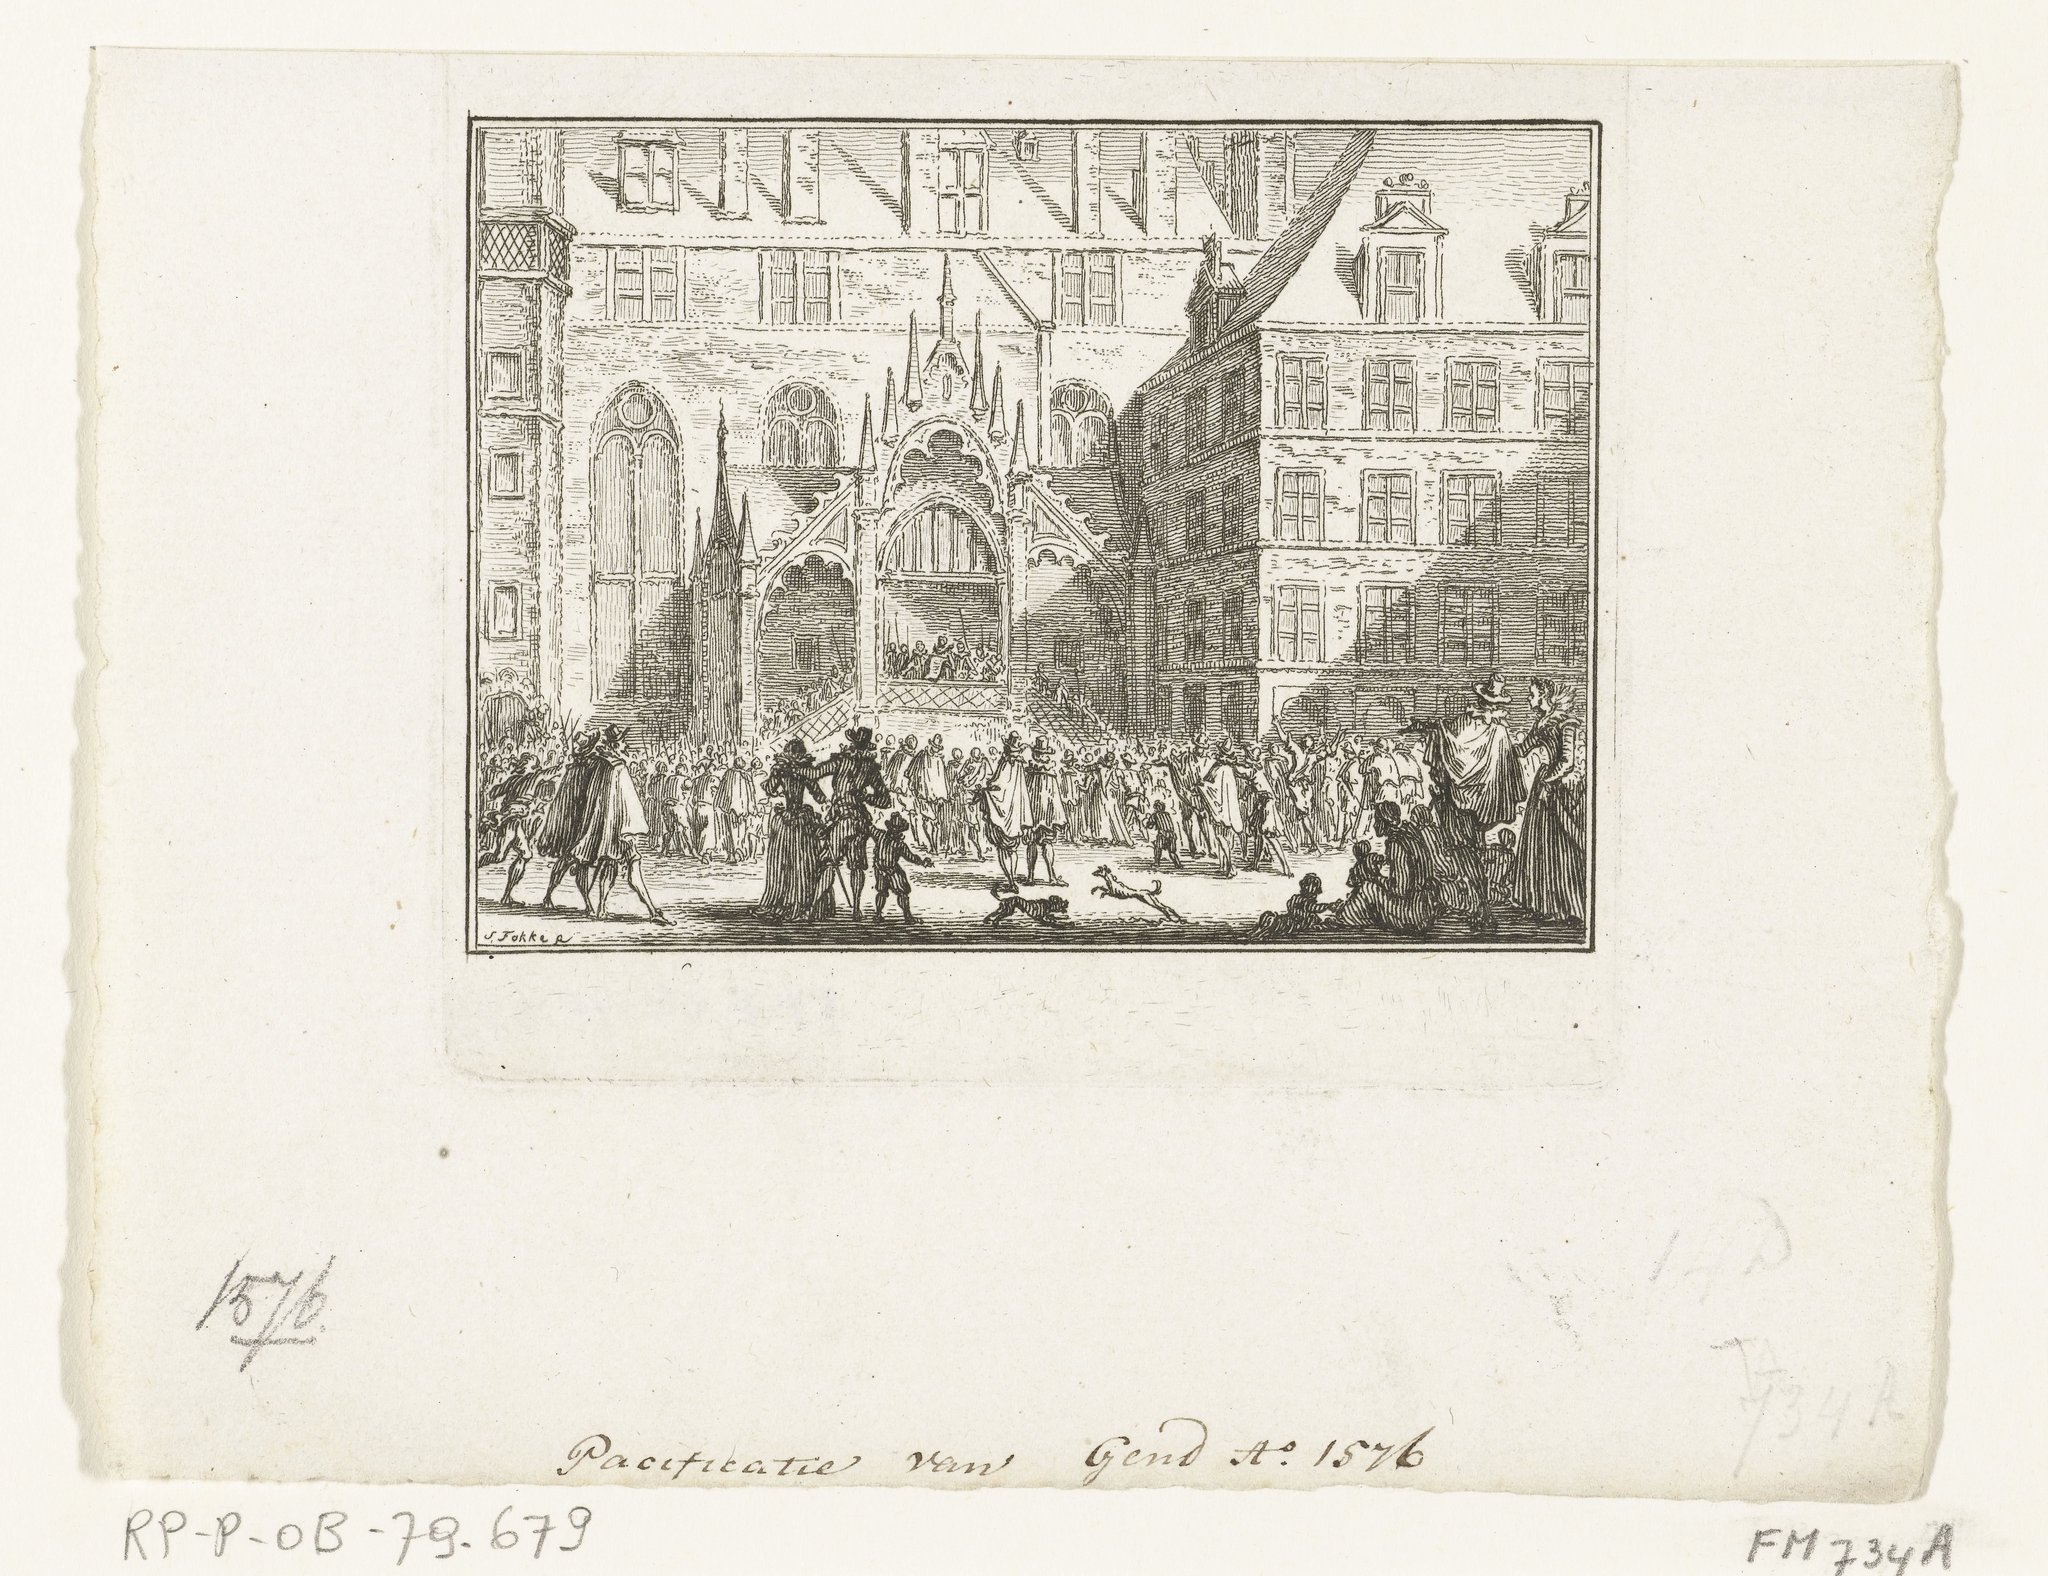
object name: print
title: Afkondiging van de Pacificatie van Gent, 1576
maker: simon fokke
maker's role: draughtsman, print maker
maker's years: 1712-1784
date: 1782-1784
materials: paper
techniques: pen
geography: northern netherlands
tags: proclamation of peace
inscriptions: inscription: ‘Pacificatie van Gend Ao. 1576’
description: Gebruikt als illustratie in: J.W. te Water, De vaderlandsche Historie van den heere J. Wagenaar, verkort, en met leerzaame aanmerkingen, ten dienste der Nederlandsche jeugd, 1784-1800, 4 delen.